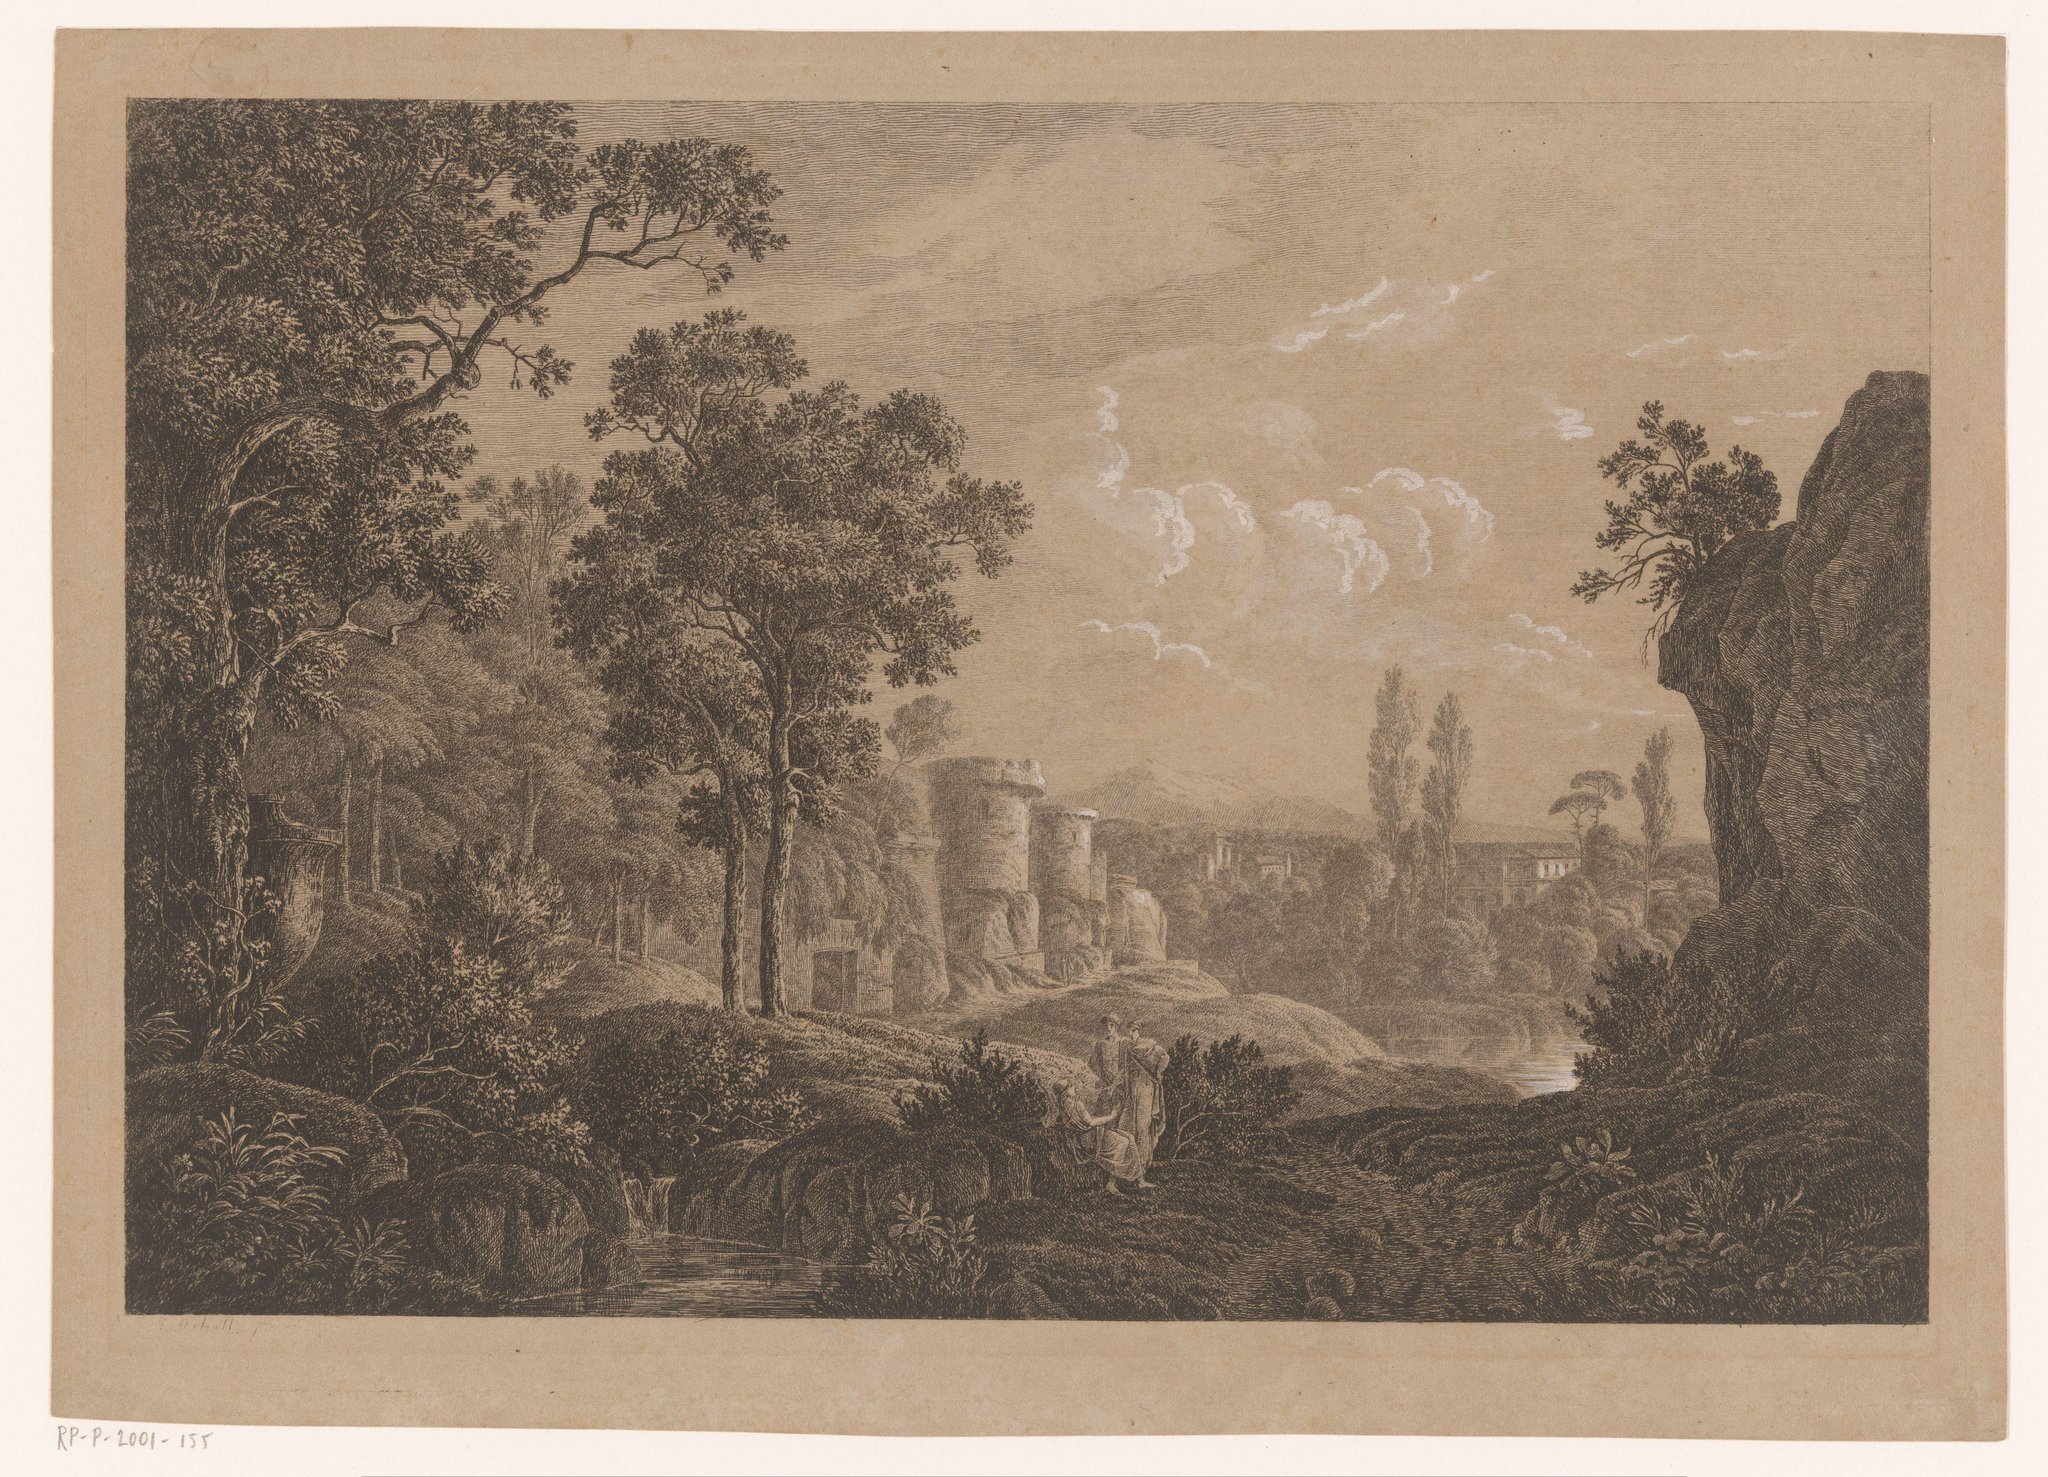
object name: print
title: Italiaans landschap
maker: joseph rebell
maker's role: print maker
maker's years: 1787-1828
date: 1807-1828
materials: paper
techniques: etching, hand coloring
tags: landscapes in the temperate zone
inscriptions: collector's mark: Lugt 2760, collector's mark: Lugt 2228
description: Italiaans landschap met twee ronde torens en gebouwen tussen het geboomte. Op de voorgrond een groepje van twee staande en een zittende figuur. Rechtsvoor rotsen, linksvoor bomen en een stroompje.